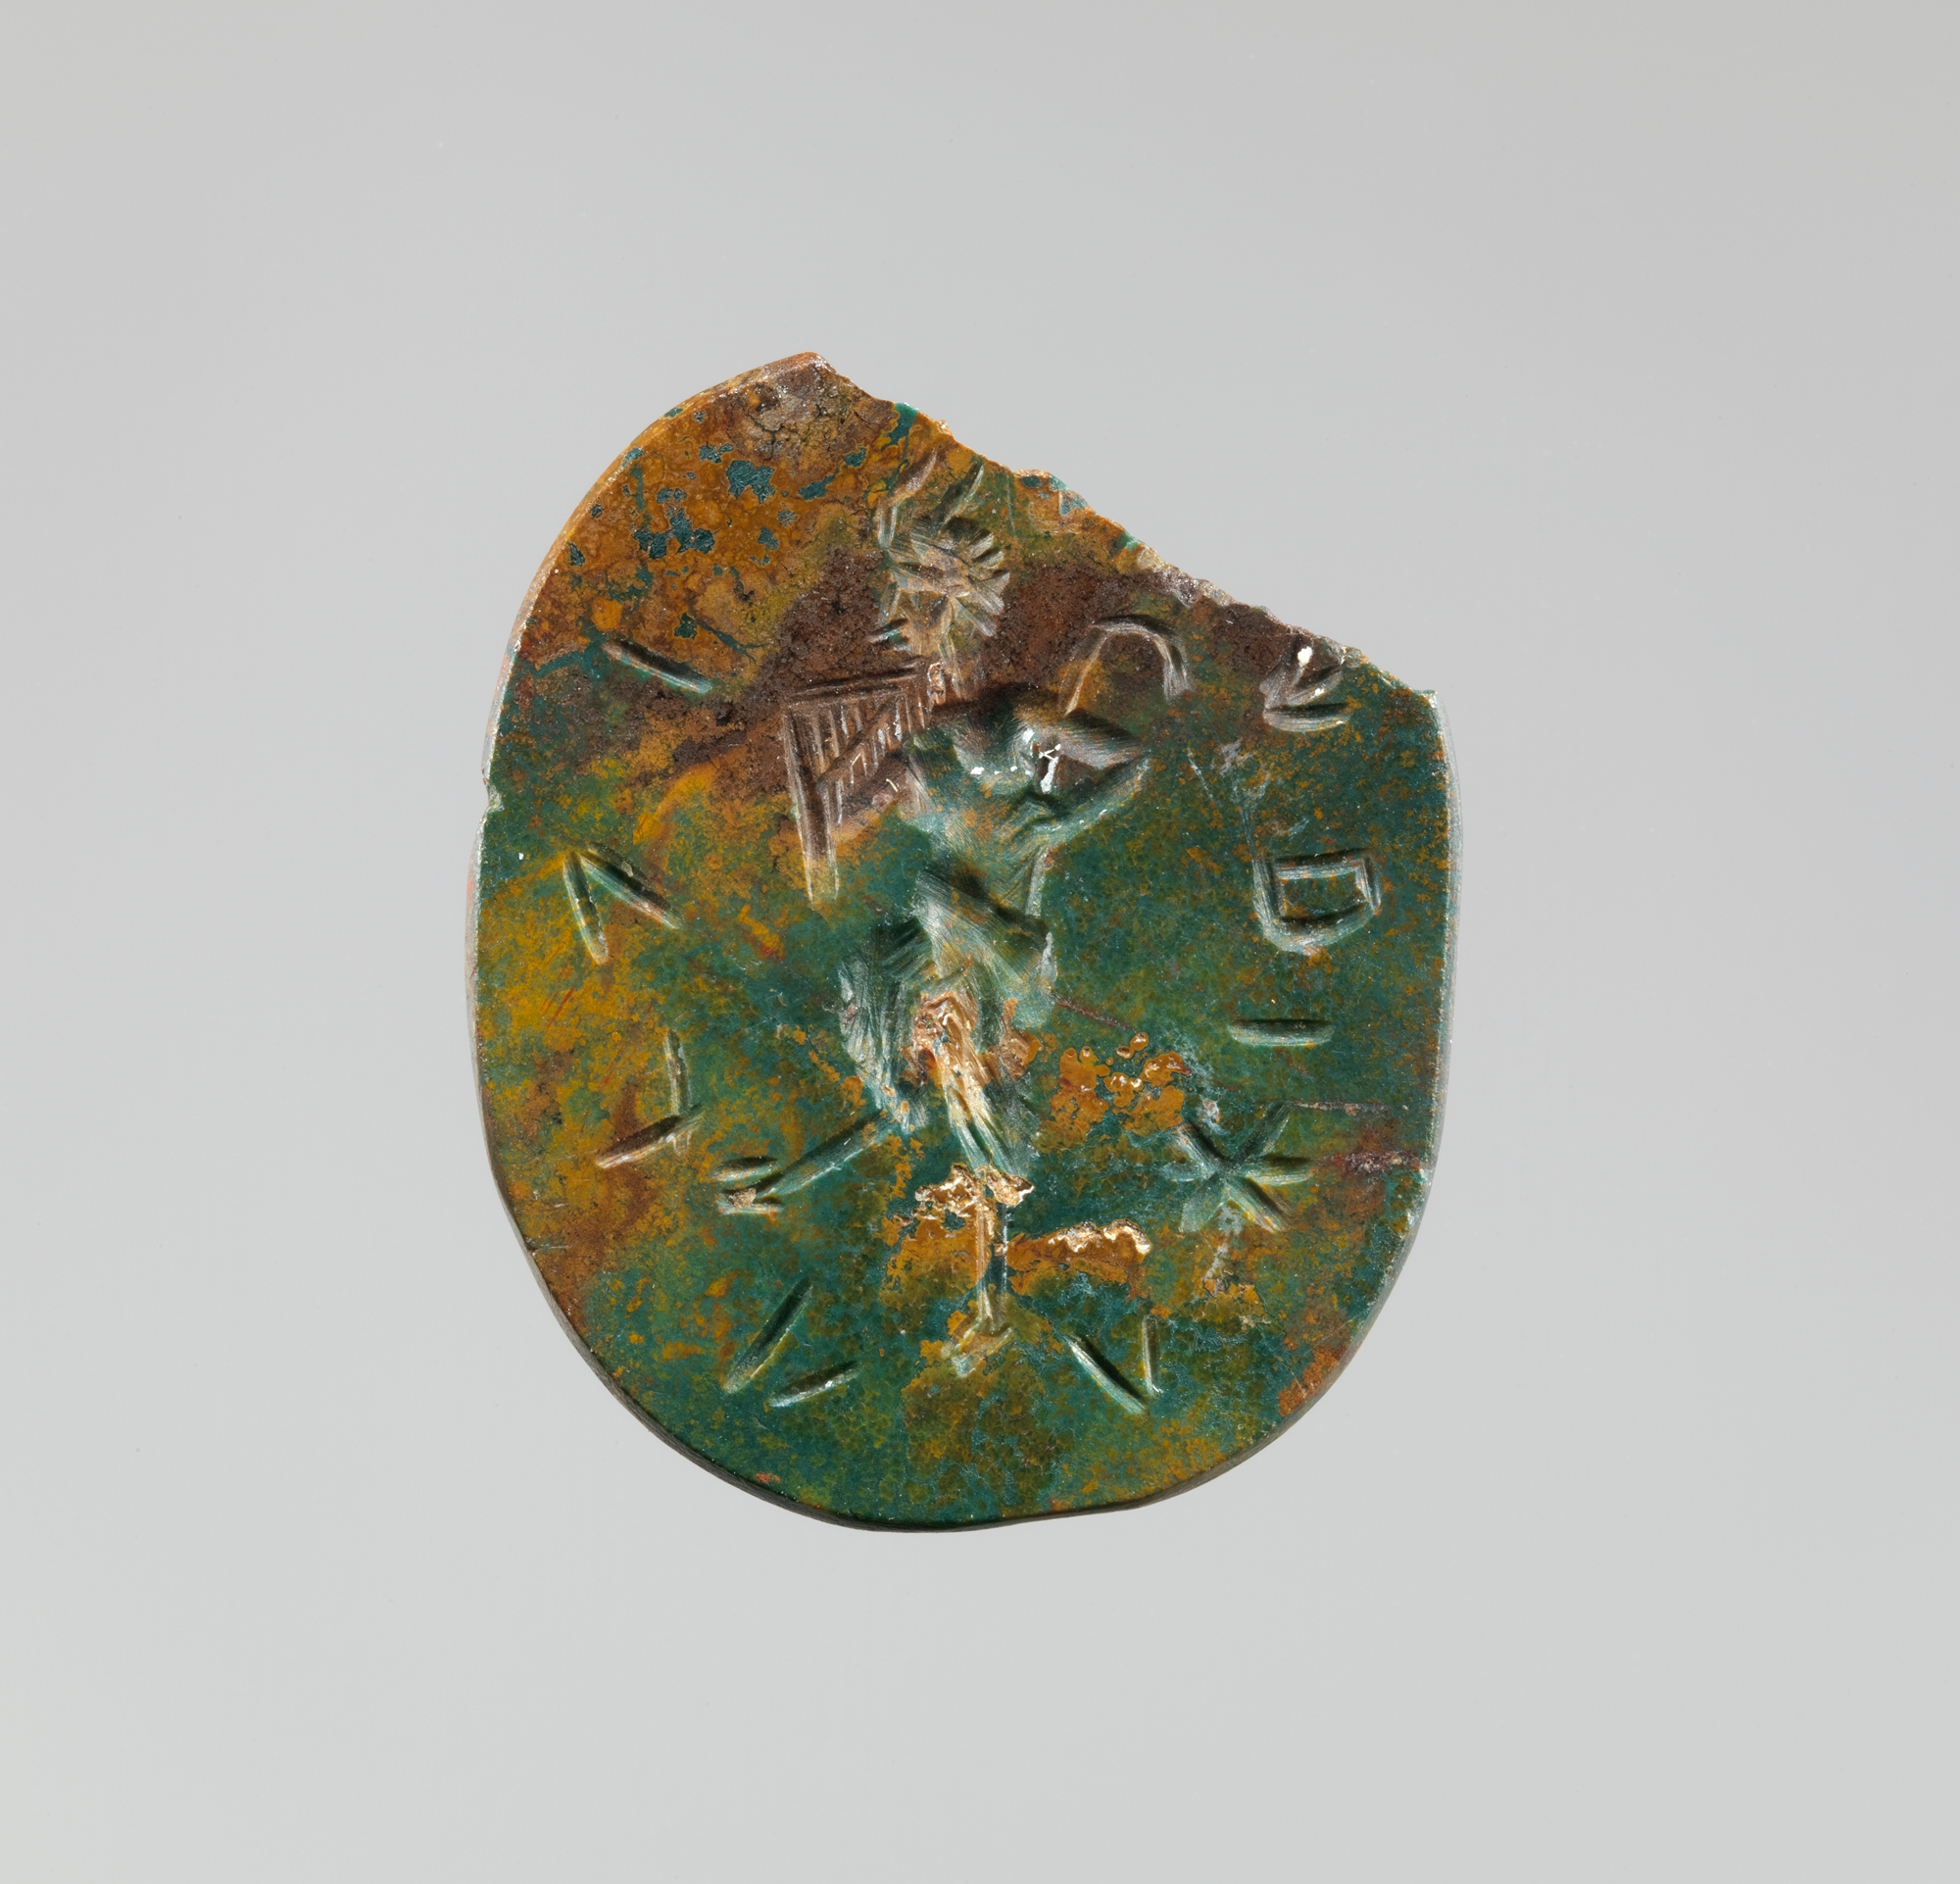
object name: intaglio, magical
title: Jasper intaglio: Horned Pan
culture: roman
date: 101-300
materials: jasper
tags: pan